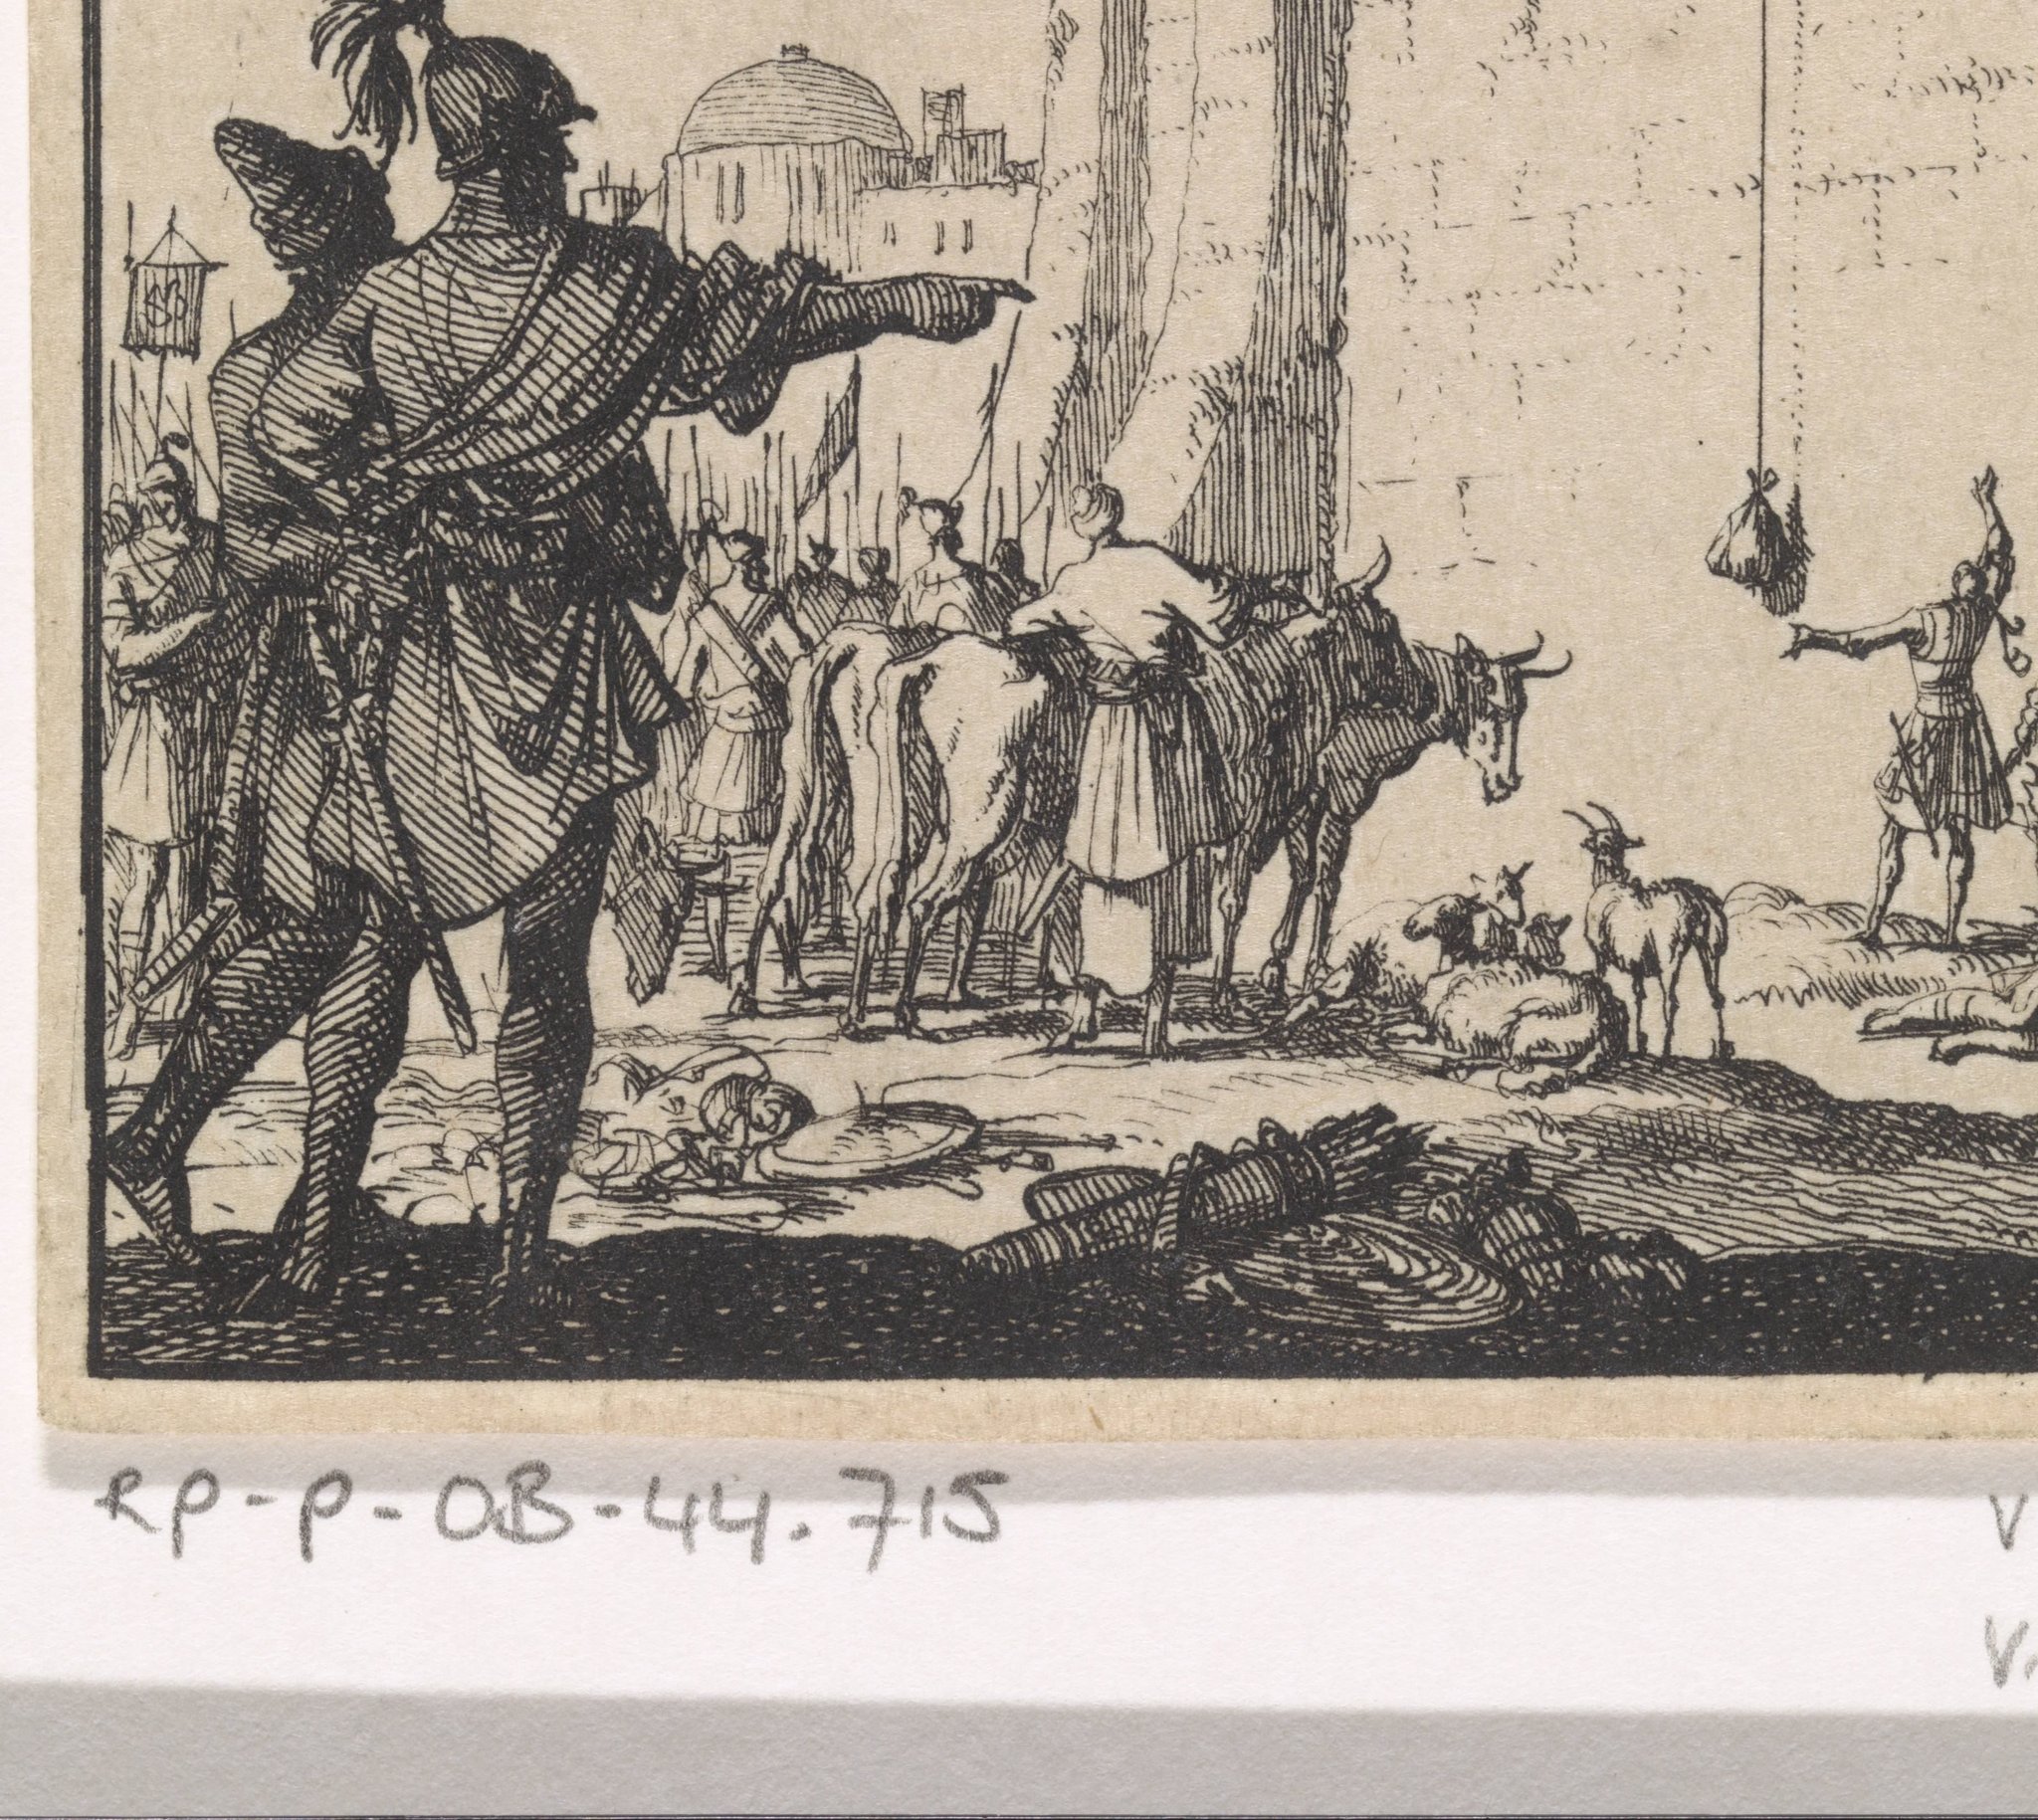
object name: print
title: De in de tempel opgesloten Joodse priesters trachten zich voor het paasfeest van offerdieren te voorzien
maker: jan luyken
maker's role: draughtsman, print maker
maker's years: 1649-1712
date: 1698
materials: paper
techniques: etching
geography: amsterdam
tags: fourth book of the maccabees (4 maccabees)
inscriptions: collector's mark: Lugt 2228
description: Proefdruk van illustratie uit: Josephus, Flavius. XX. boeken van de oude geschiedenissen der joden, 4 delen. Amsterdam: Barent Visscher, Willem de Coup, Willem van Lamsveld, Andries van Damme, 1698, dl. II.